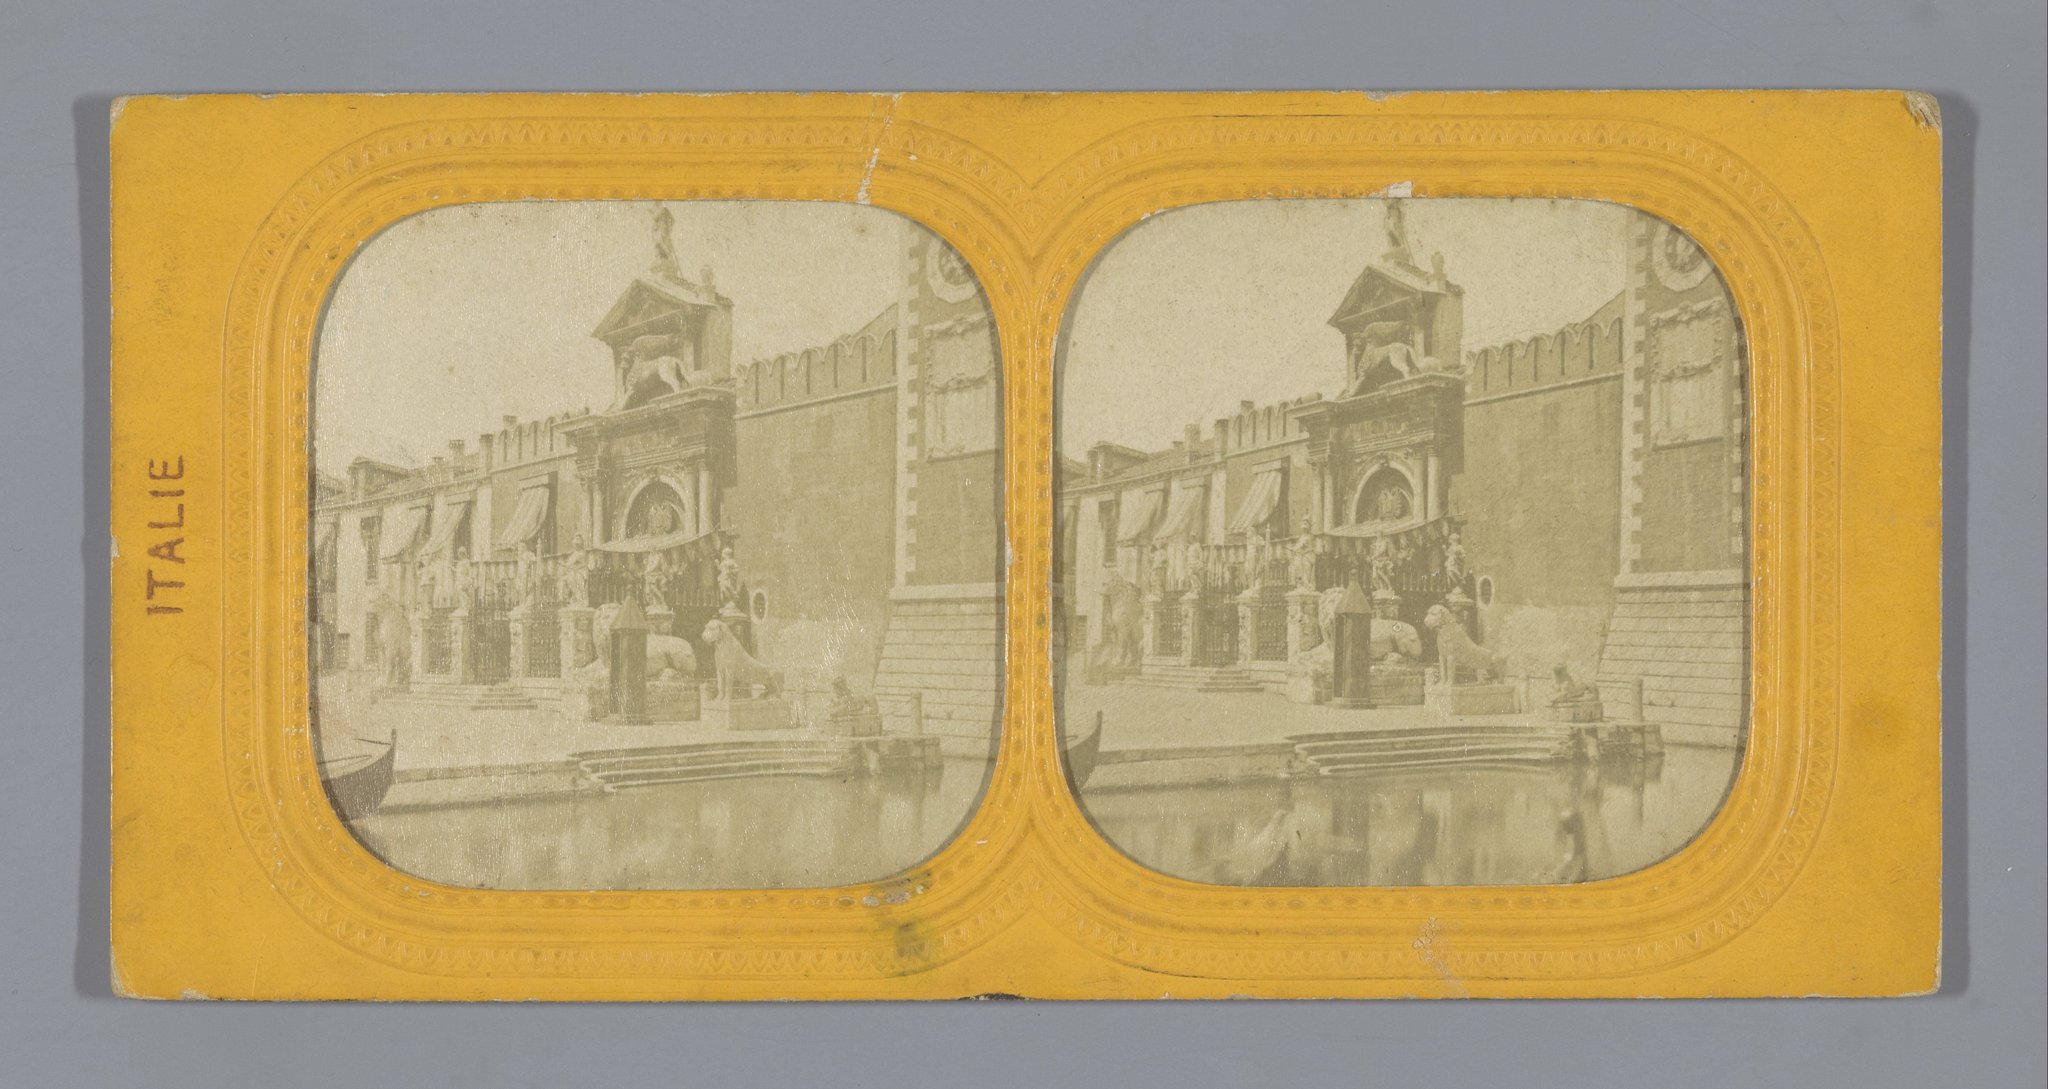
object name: tissue stereograph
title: Italie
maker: Anonymous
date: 1855-1875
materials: cardboard, paper, photographic support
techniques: albumen print, hand coloring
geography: venice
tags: gate, entrance, ammunition store, arsenal